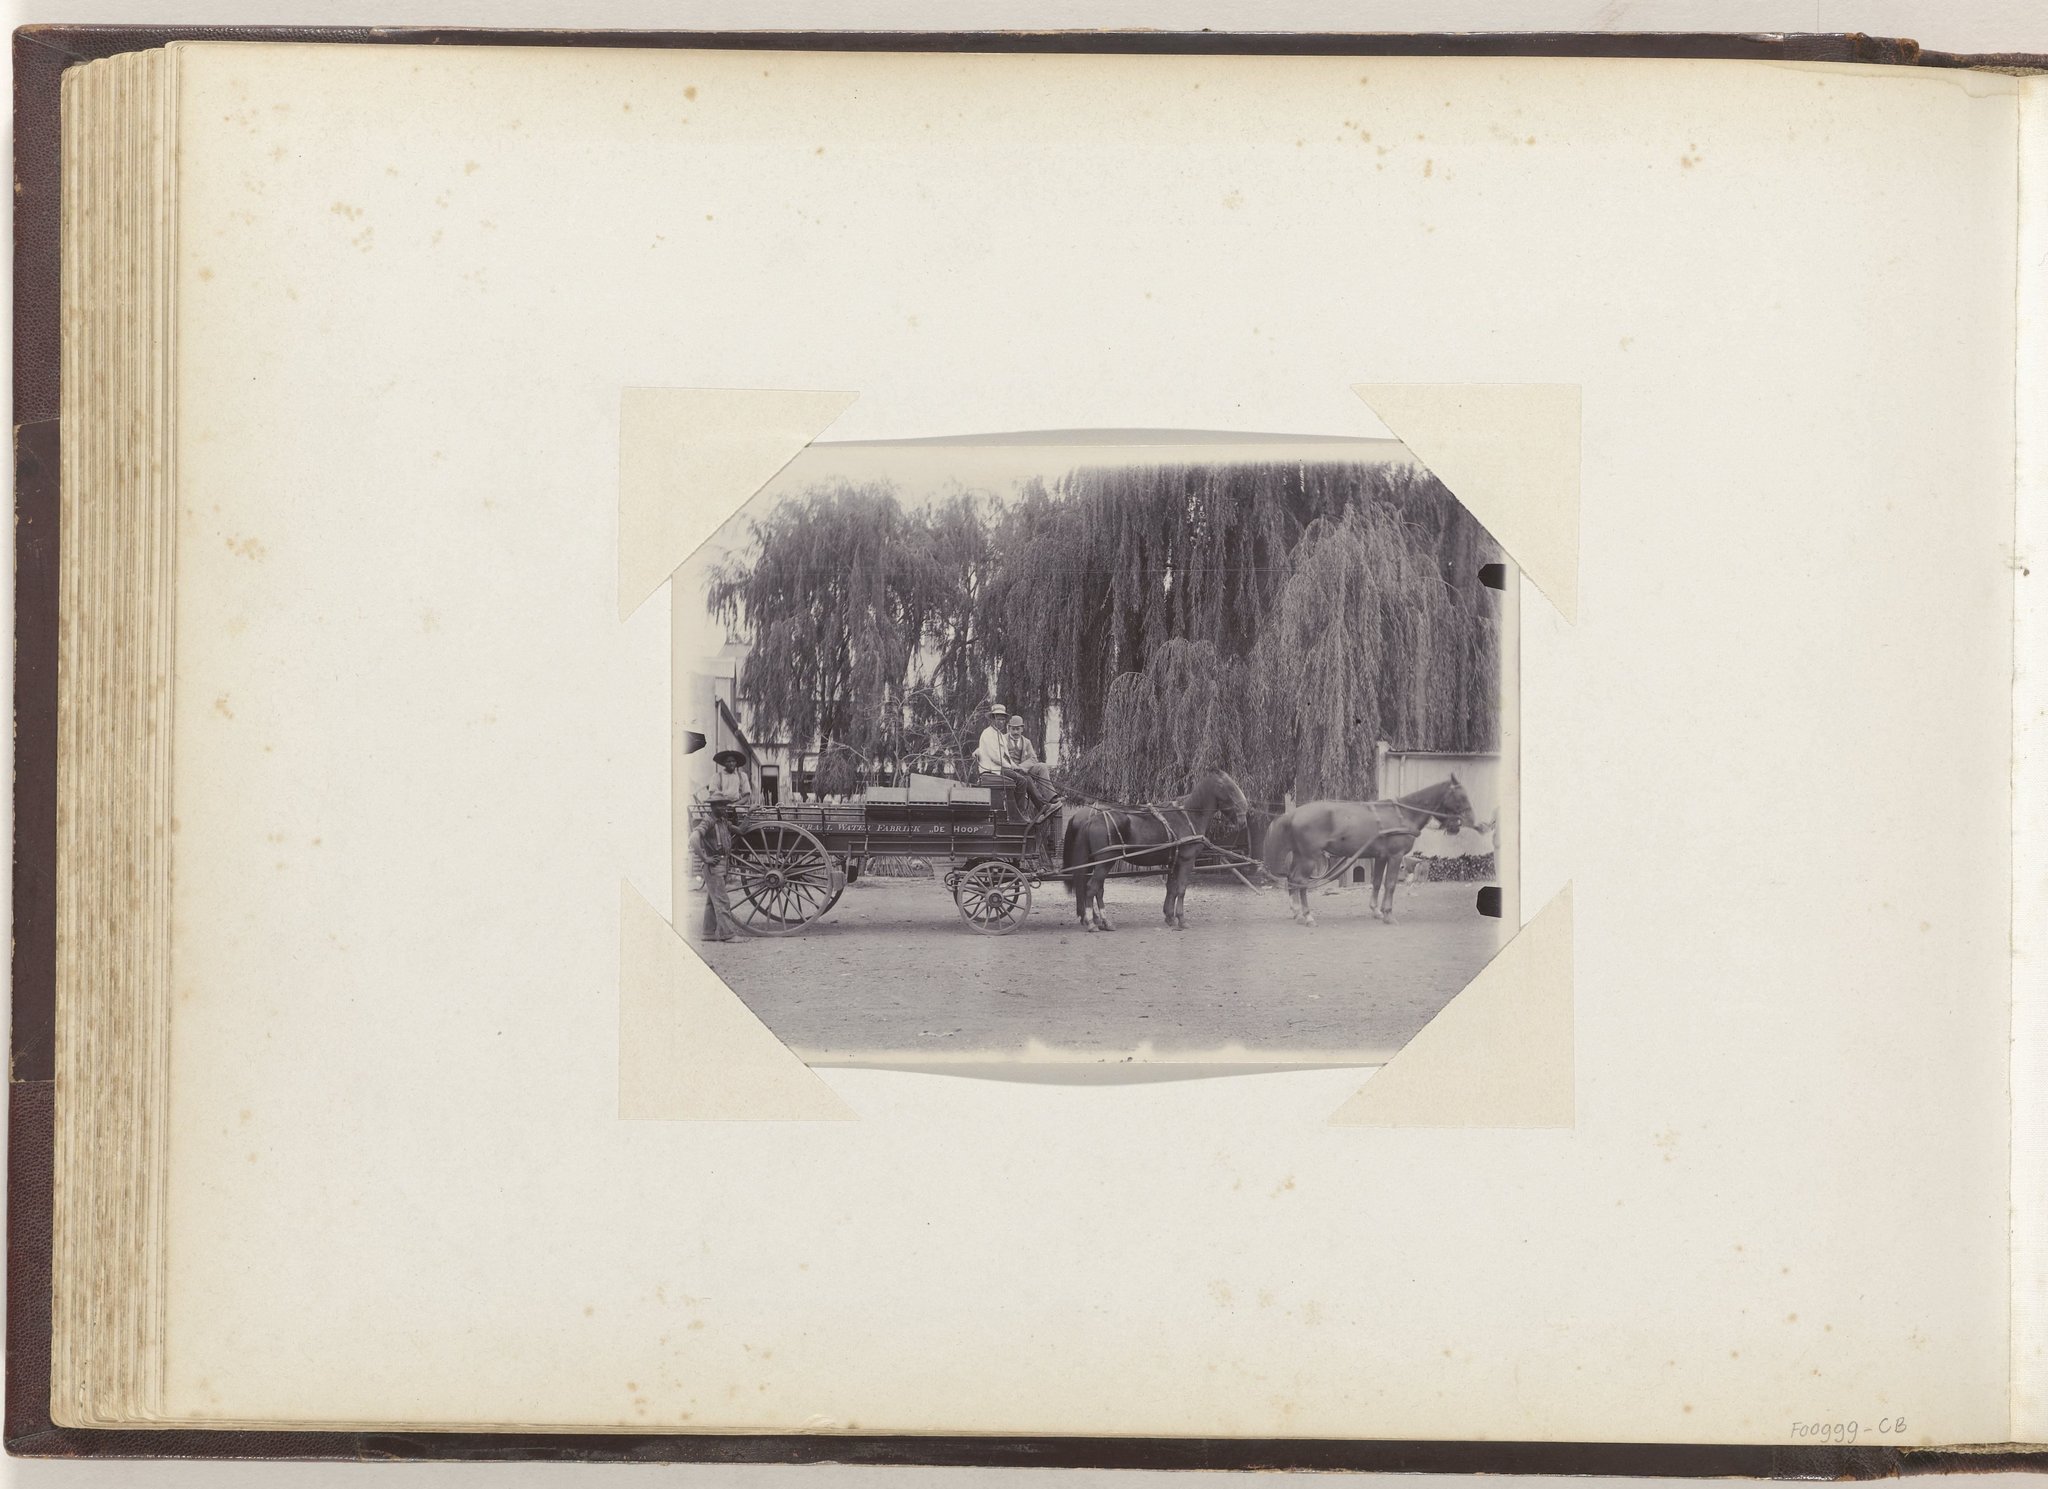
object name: photograph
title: Paard en wagen van mineraalwater-fabriek De Hoop in Zuid-Afrika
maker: Anonymous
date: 1896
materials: paper, photographic support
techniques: daylight paper print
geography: south africa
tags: four-wheeled, animal-drawn vehicle, e.g.: cab, carriage, coach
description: Onderdeel van Album met 191 foto's van een reis naar en door Zuid-Afrika.